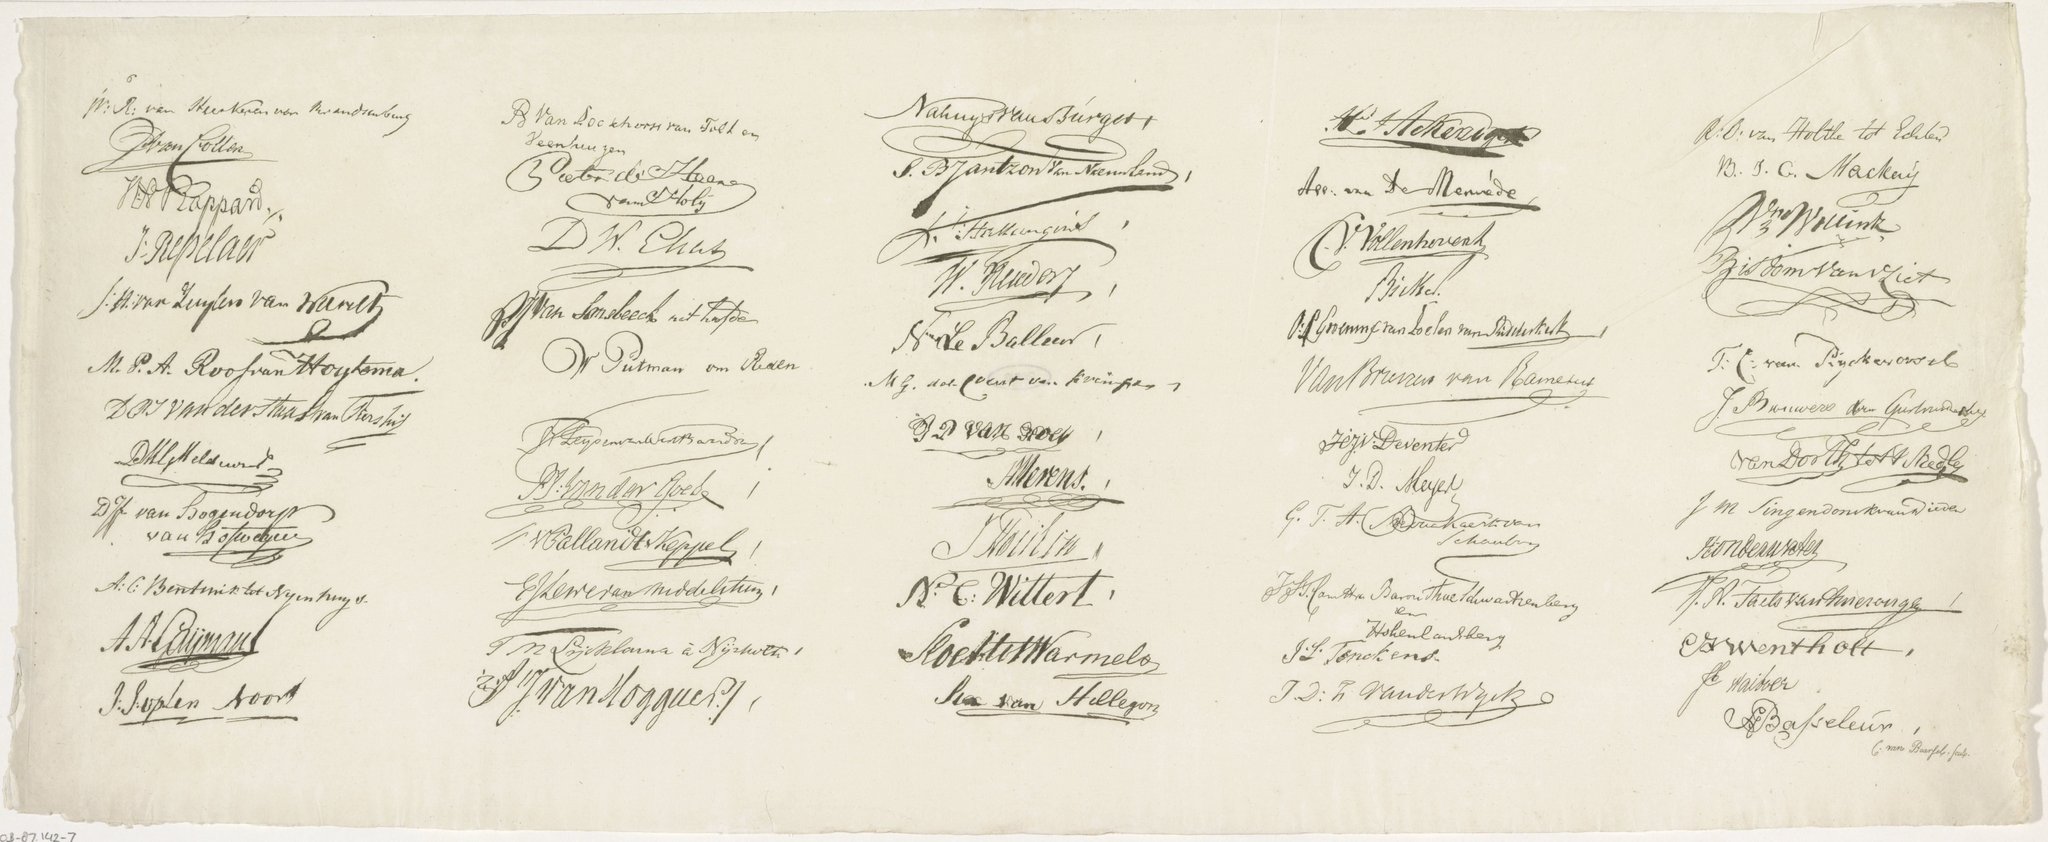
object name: print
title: Naamteekeningen der leden van de Vergadering der Aanzienlijken, ter goed- of afkeuring der Grondwet voor de Vereenigde Nederlanden. Gegraveerd naar de oorspronkelijke handteekeningen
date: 1814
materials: paper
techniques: etching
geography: the hague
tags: the hague, berlin, william i of the netherlands, handwriting, written text, amsterdam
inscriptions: collector's mark: Lugt 2228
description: Blad nr. 6 uit de serie van negen bladen met in facsimile de handtekeningen van de leden van de Vergadering der Aanzienlijken bijeen ter onderhandeling over de nieuwe grondwet, te Amsterdam op 29 maart 1814.